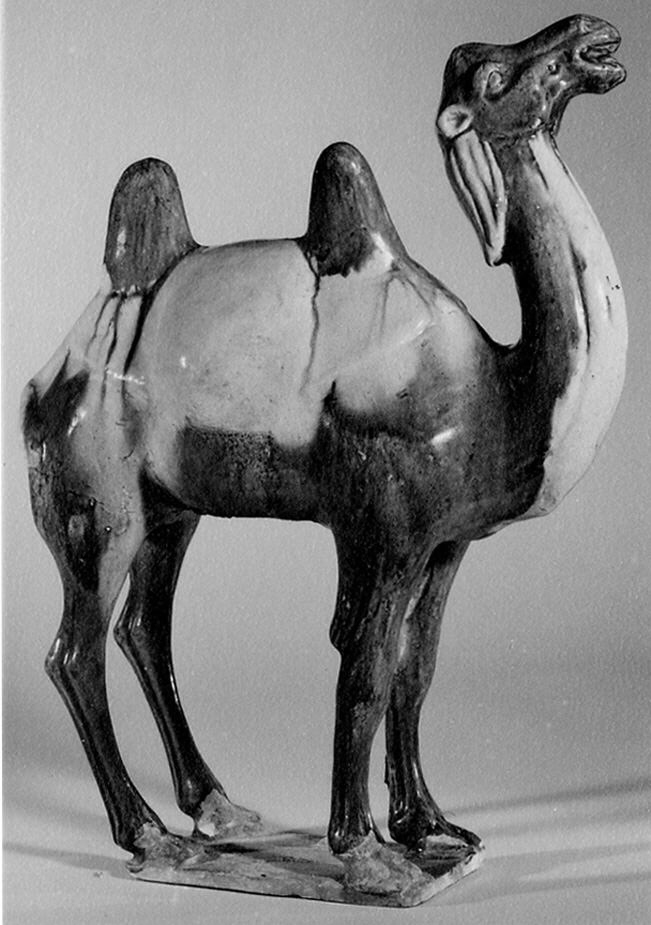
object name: figure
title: Camel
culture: chinese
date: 701-800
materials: earthenware, glaze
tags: camels